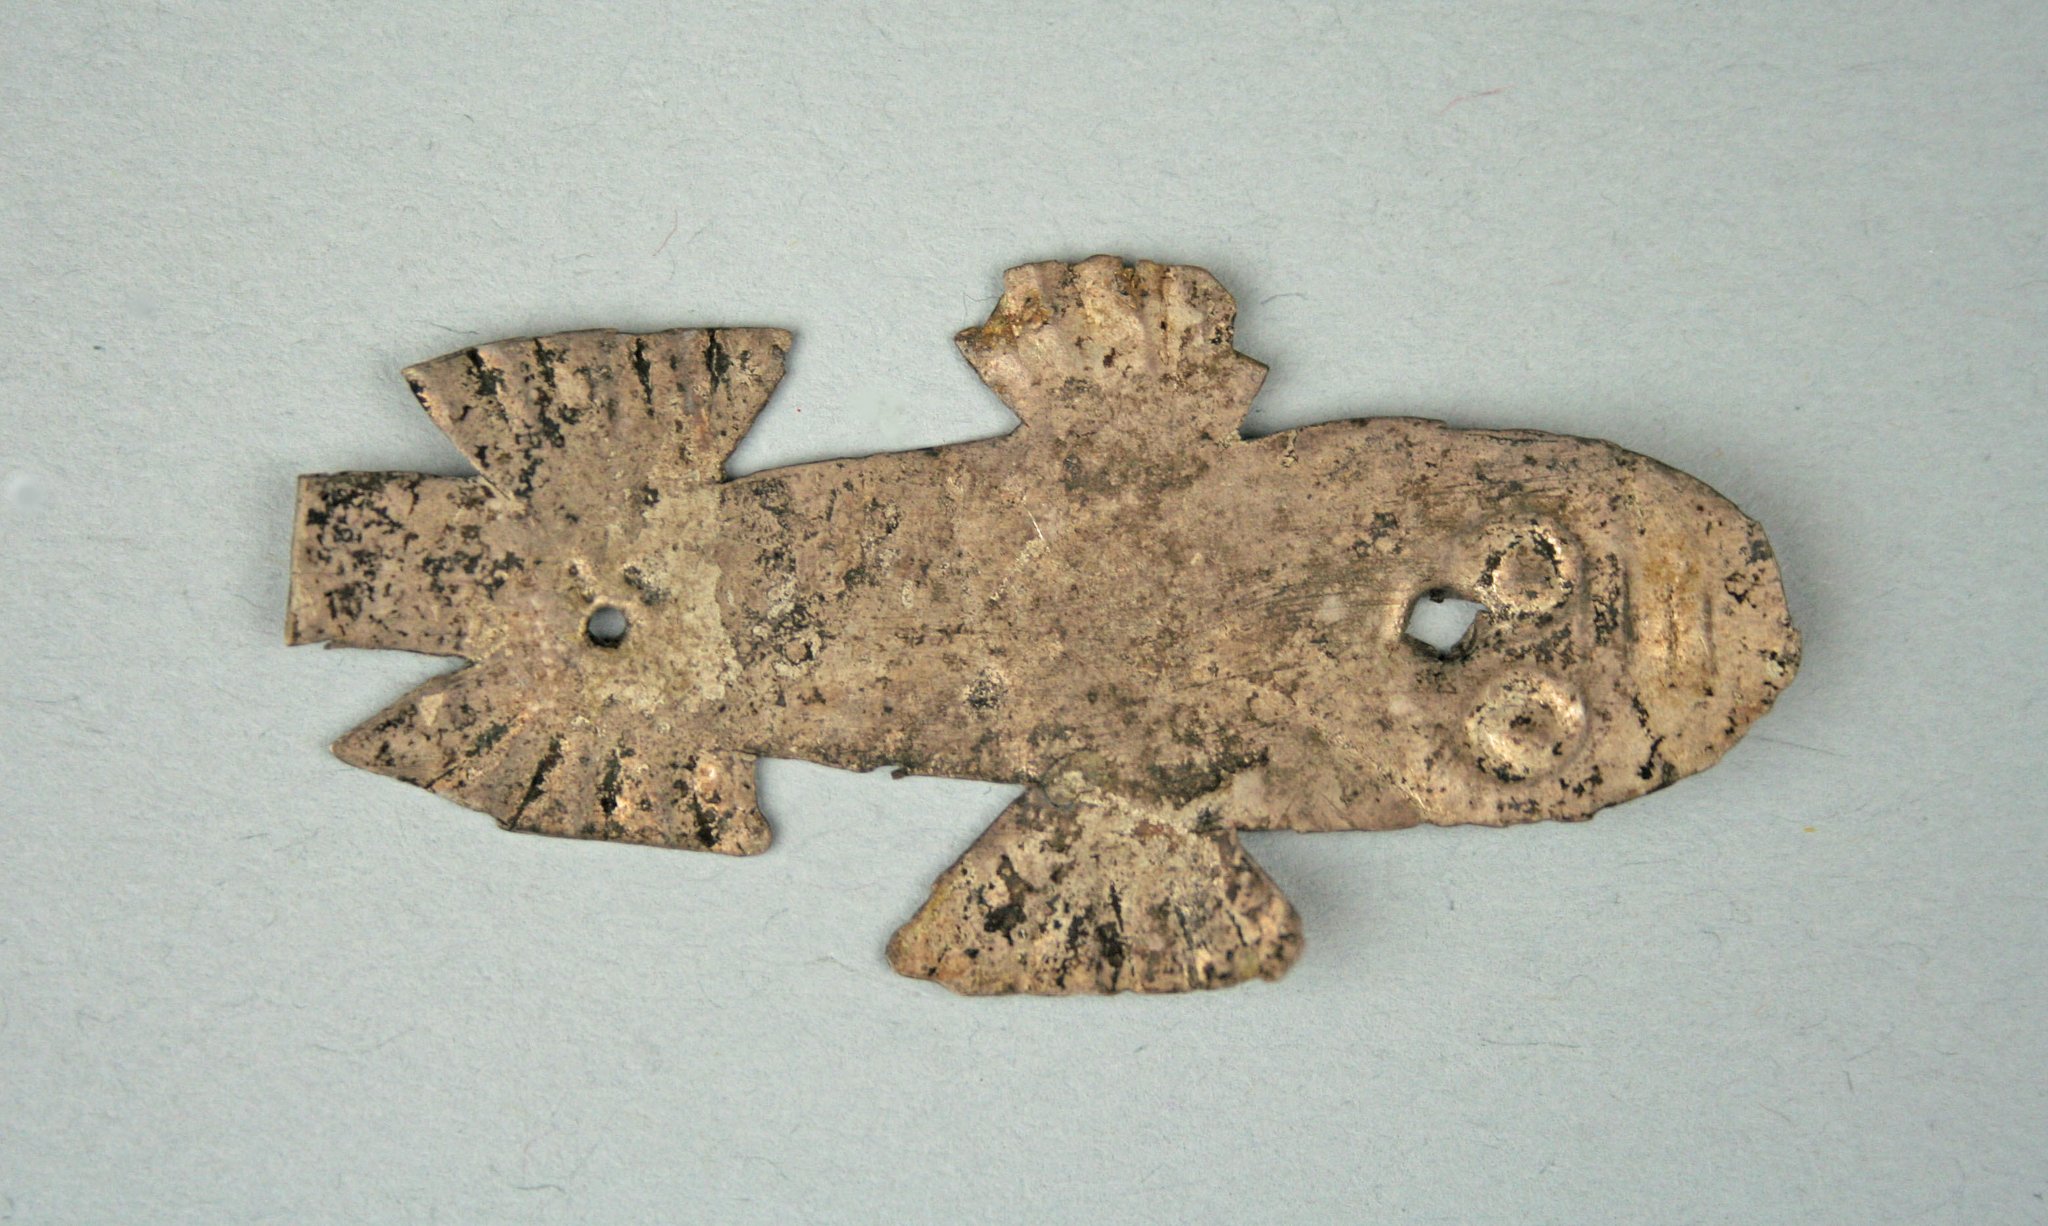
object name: ornament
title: Fish Ornament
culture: peruvian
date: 1001-1200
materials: silver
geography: peru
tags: fish